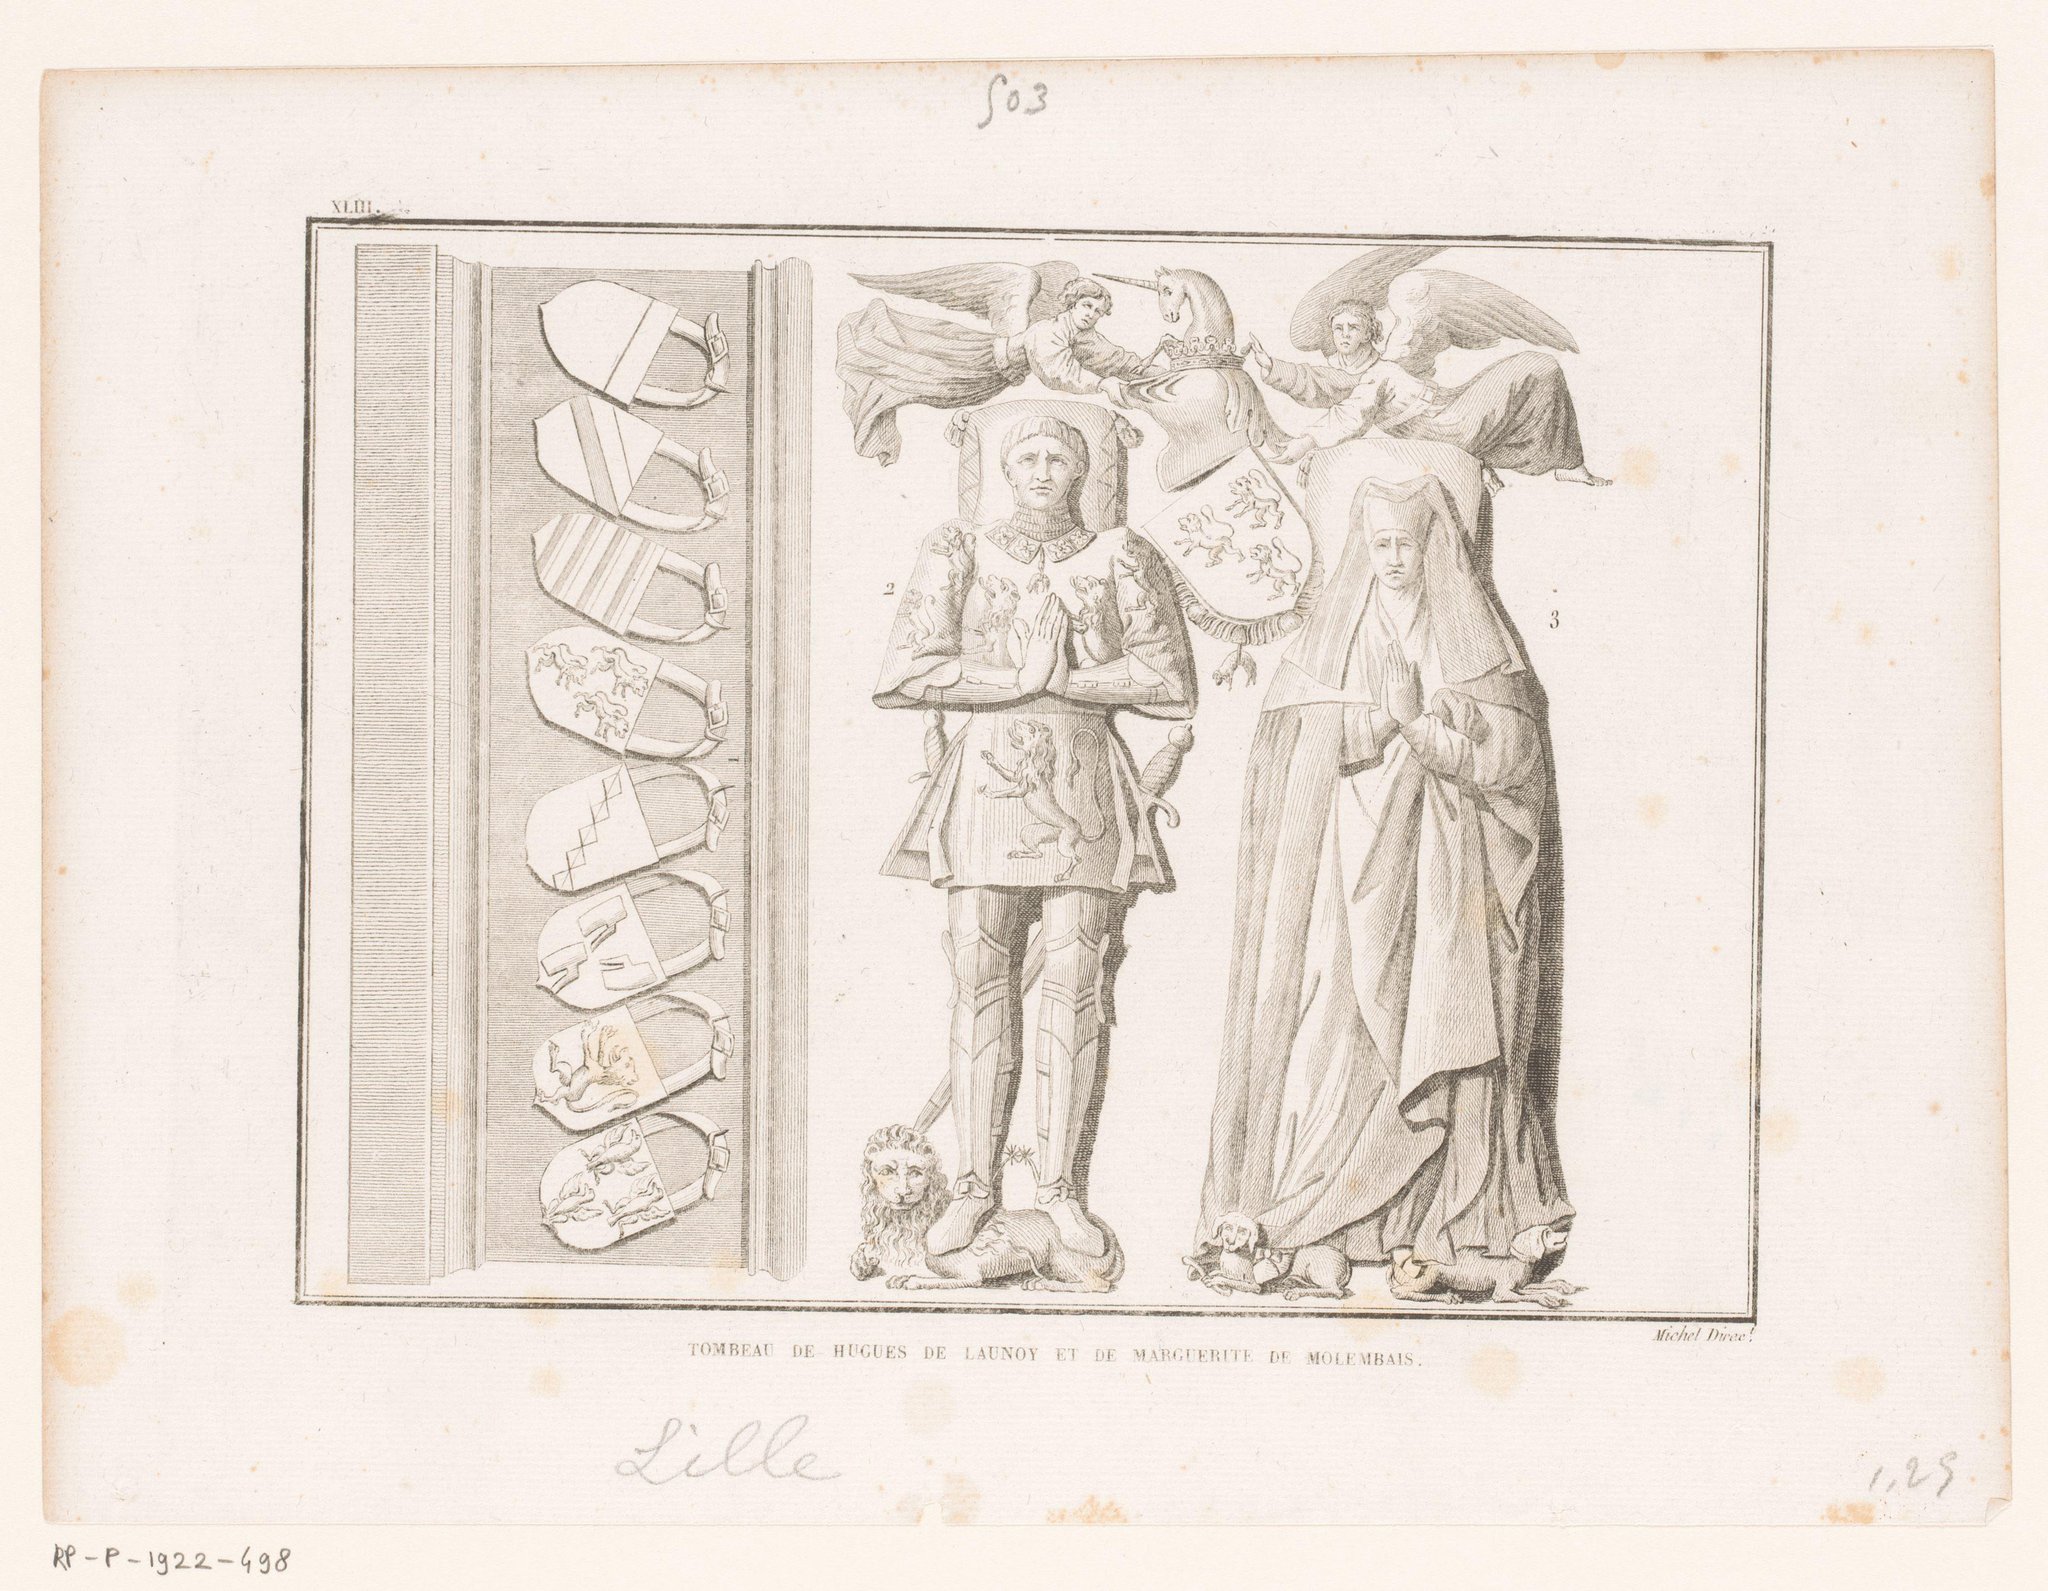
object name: print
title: Tombeau de Hugues de Launoy et de Marguerite de Molembais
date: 1750-1850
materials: paper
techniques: etching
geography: france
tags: lille, effigy, 'gisant' (portrait-figure on closed coffin or in 'castrum doloris'), transi, historical persons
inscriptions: collector's mark: Lugt 2233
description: Mogelijk een prent uit een onbekend boek.